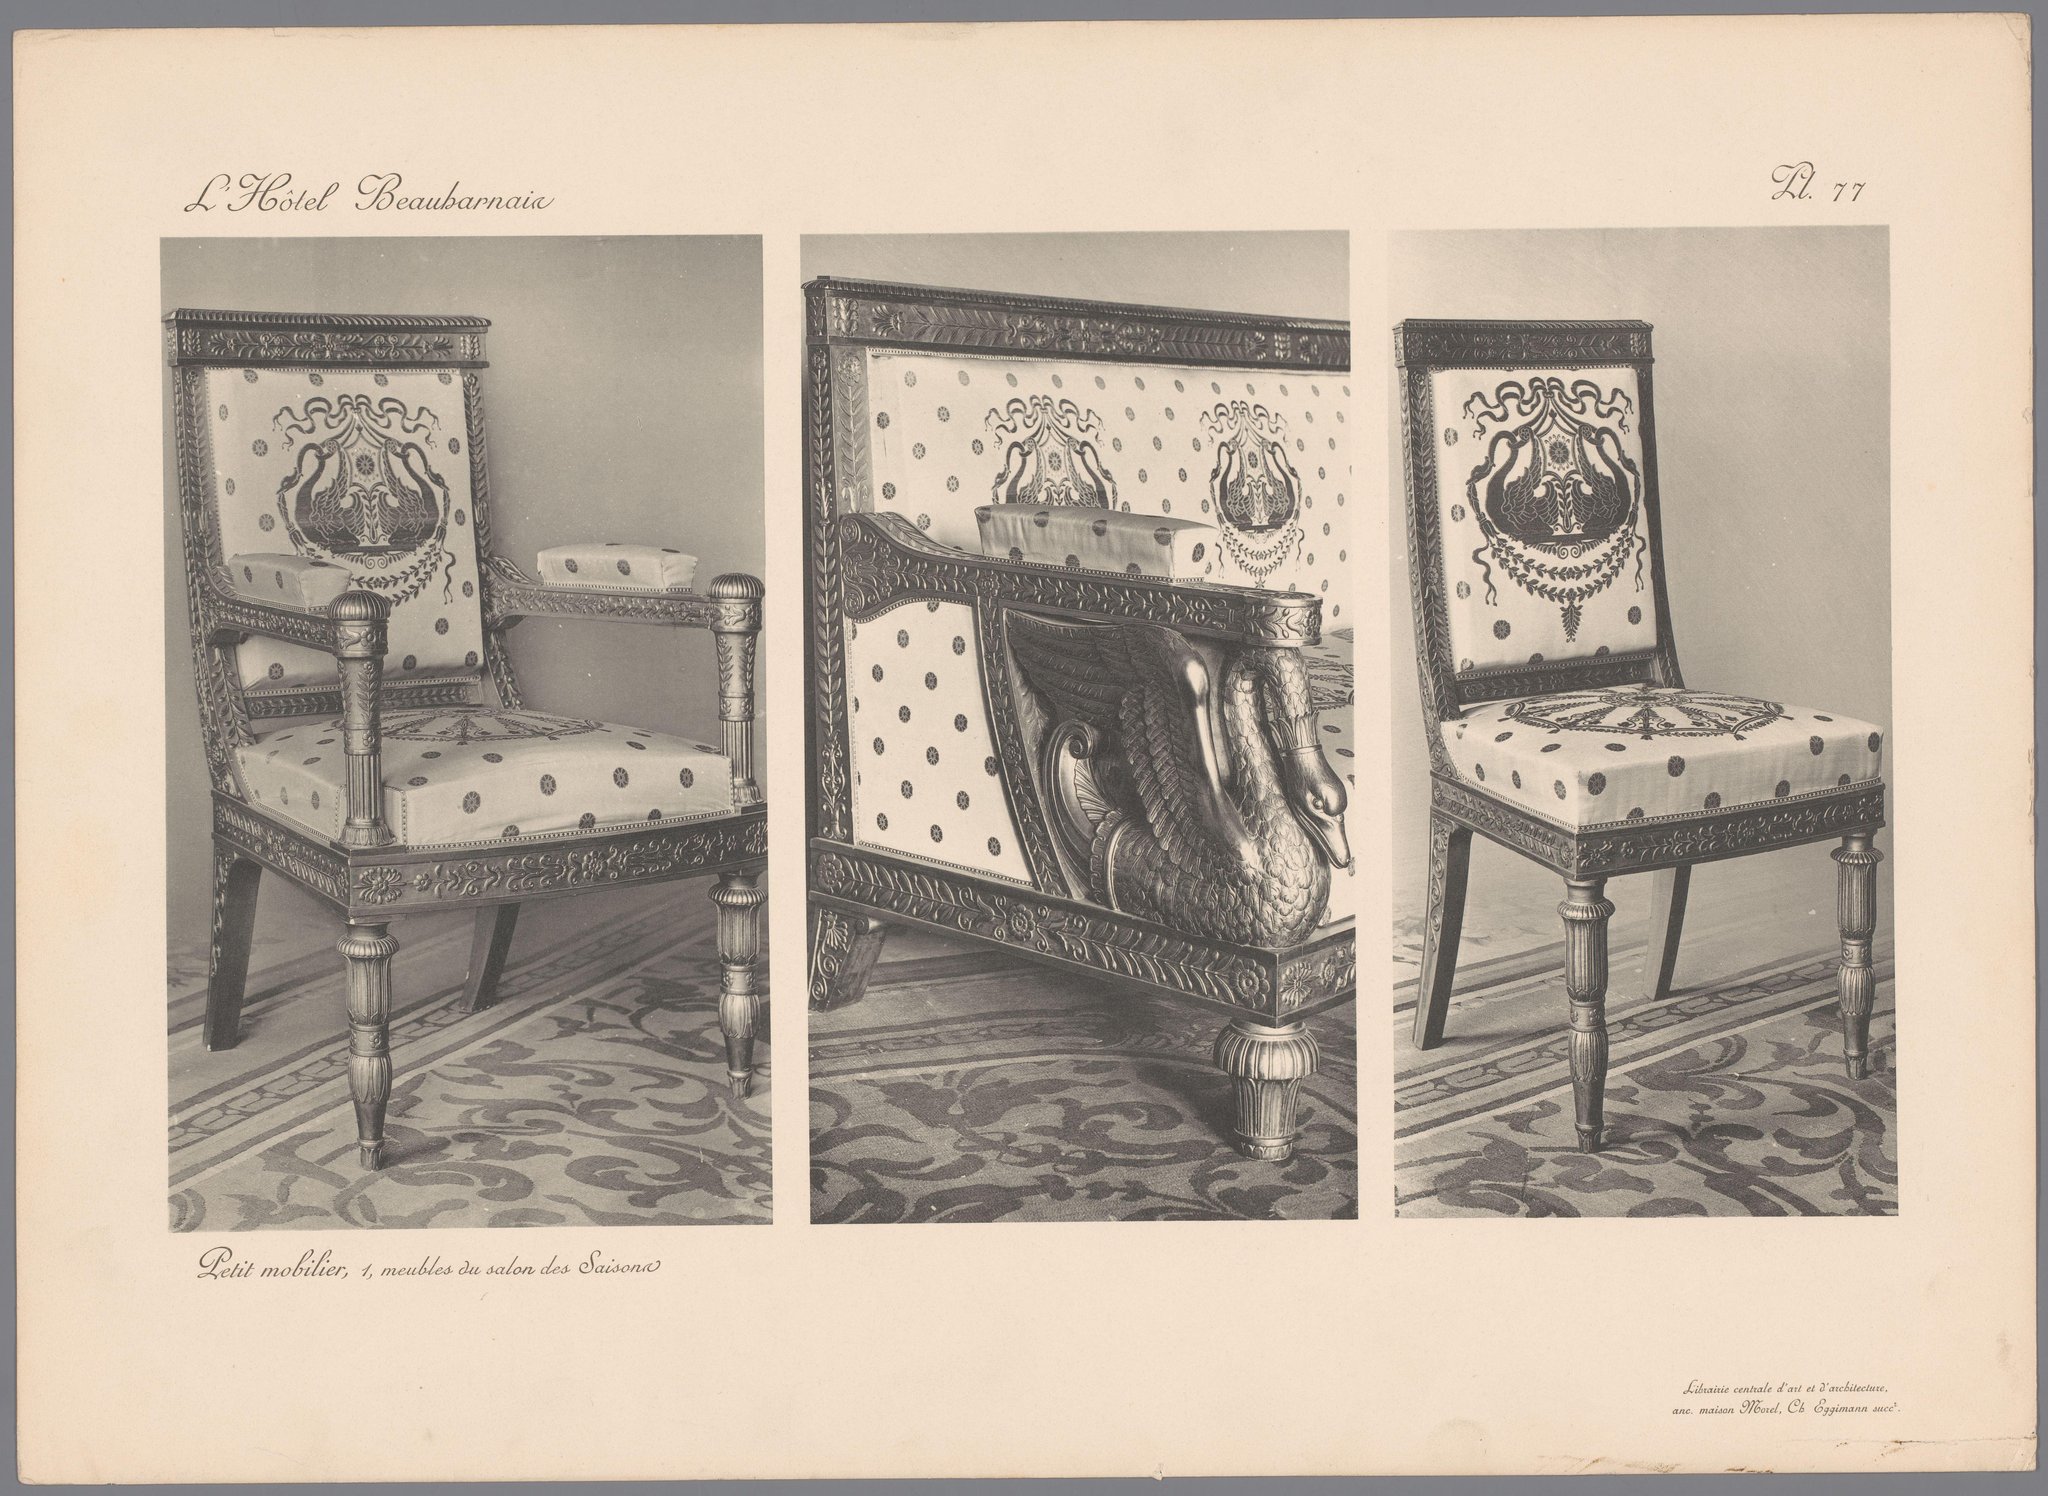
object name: photomechanical print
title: Petit Mobilier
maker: Anonymous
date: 1875-1930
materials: paper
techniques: photograph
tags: armchair, seat, chair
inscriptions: inscription: ‘1, meubles du salon des Saisons’, number: ‘77’, collector's mark: ‘Rijks normaalschool voor teekenonderwijzers Amsterdam’